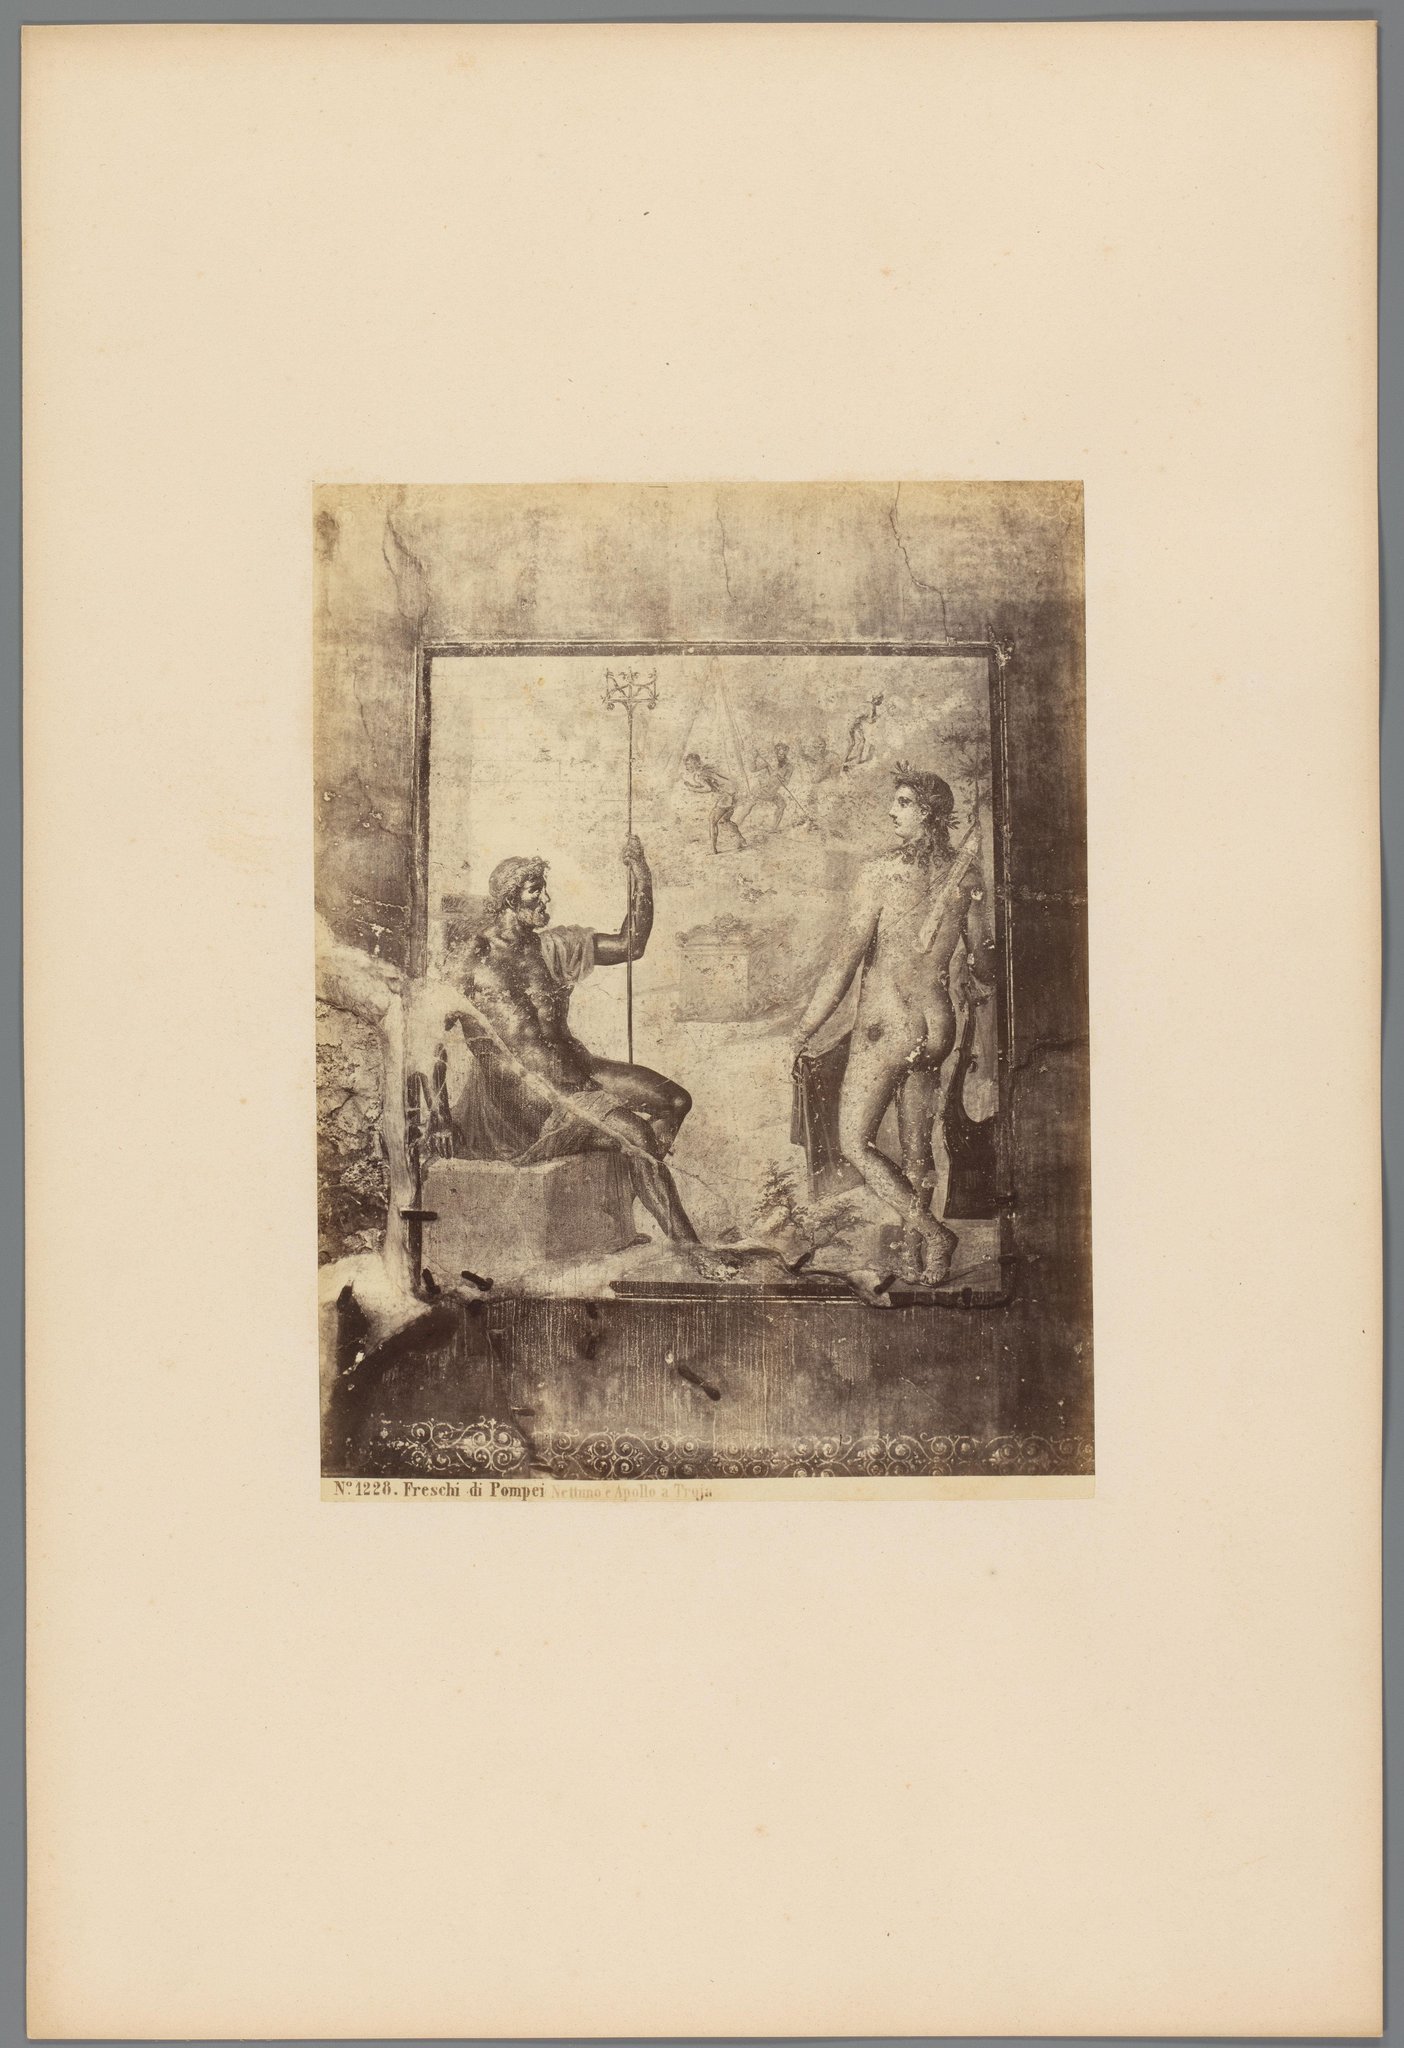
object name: photograph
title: Fotoreproductie van een fresco voorstellende Neptunus en Apollo, Pompeï, Italië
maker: Anonymous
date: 1851-1900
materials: cardboard, paper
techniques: albumen print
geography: pompeii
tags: (story of) neptune (poseidon), (story of) apollo (phoebus), wall-covering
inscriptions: number: ‘No. 1228.’